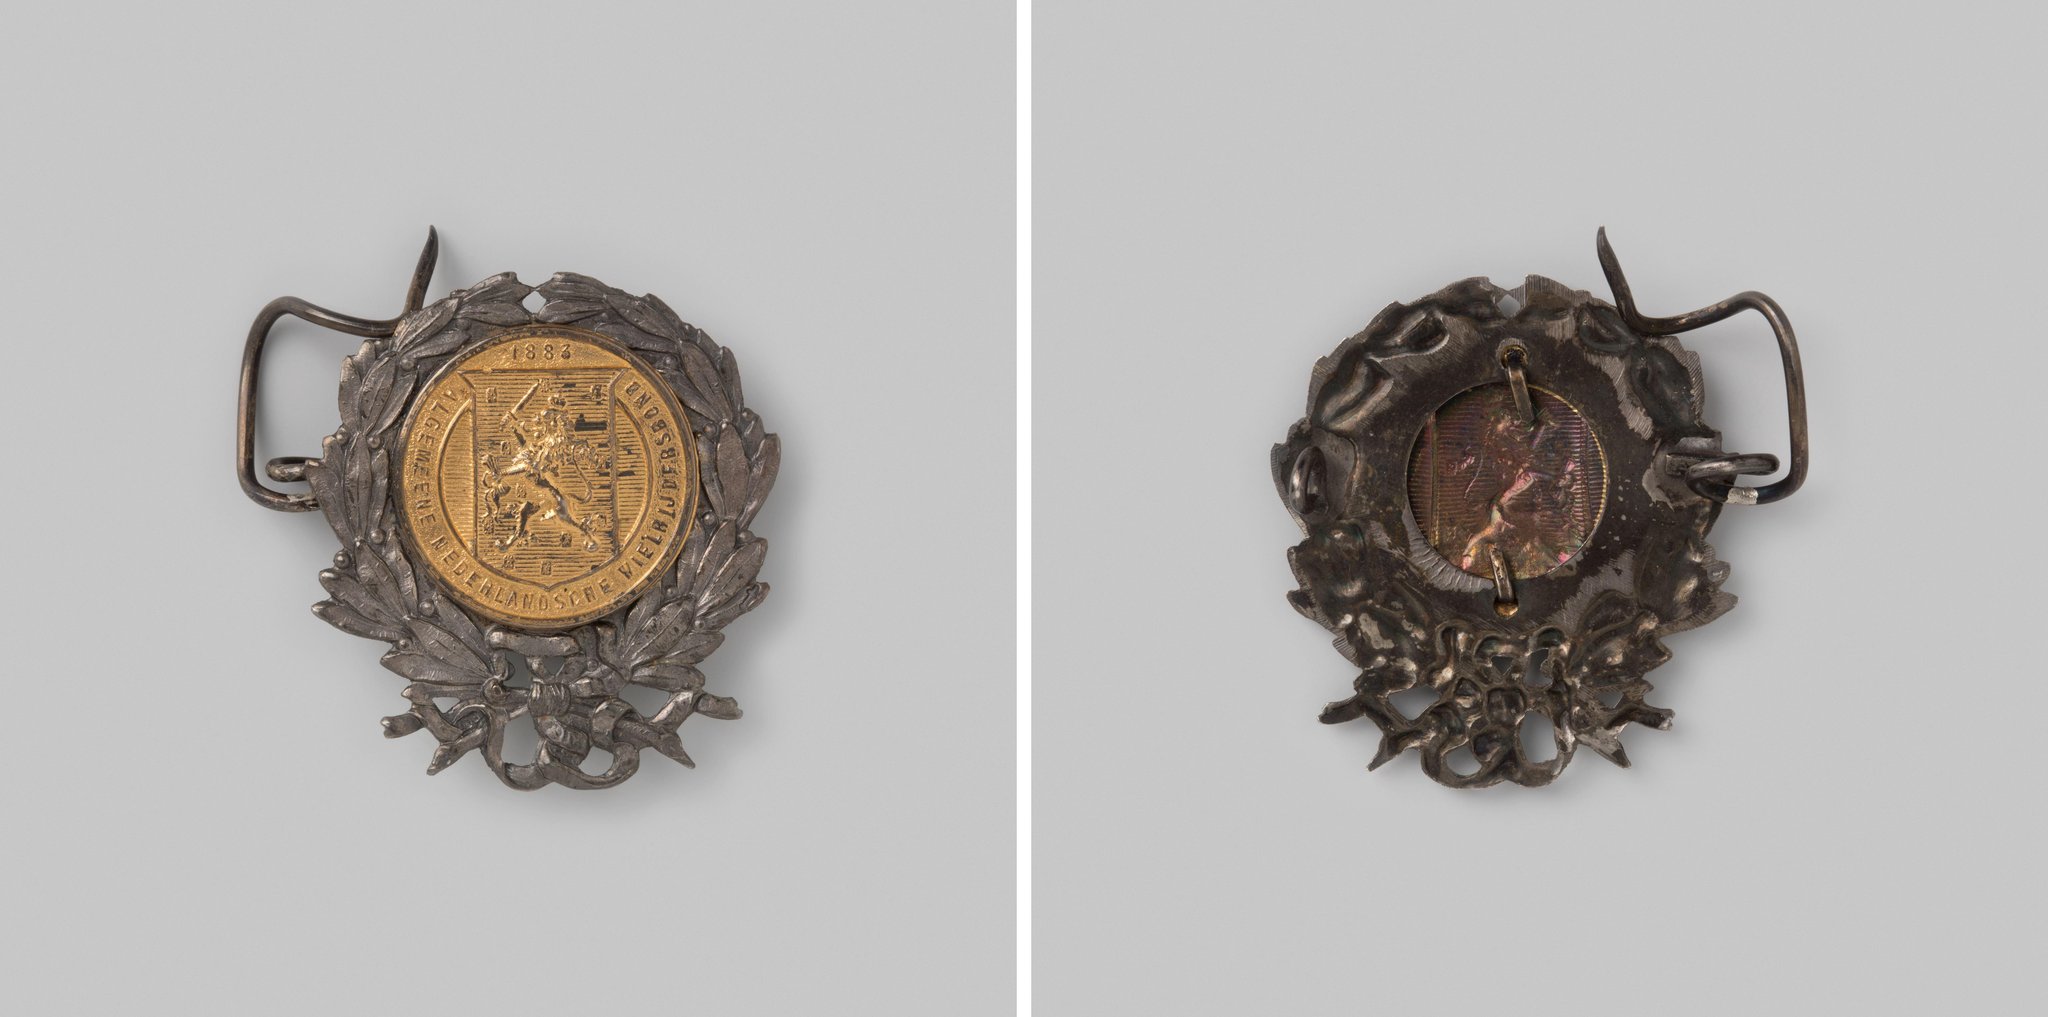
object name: insignia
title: Algemene Nederlandse Wielrijders Bond, 1883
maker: Anonymous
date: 1883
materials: metal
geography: netherlands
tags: the hague, amsterdam, sculptor, bart van hove, netherlands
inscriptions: inscription: ‘ALGEMEENE NEDERLANDSCHE WIELRIJDERSBOND 1883’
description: Speldje in de vorm van een krans waarin goudkleurige medaillon waarin de Nederlandse Leeuw met omschrift en datum. Keerzijde: kromgebogen speld met haakje.